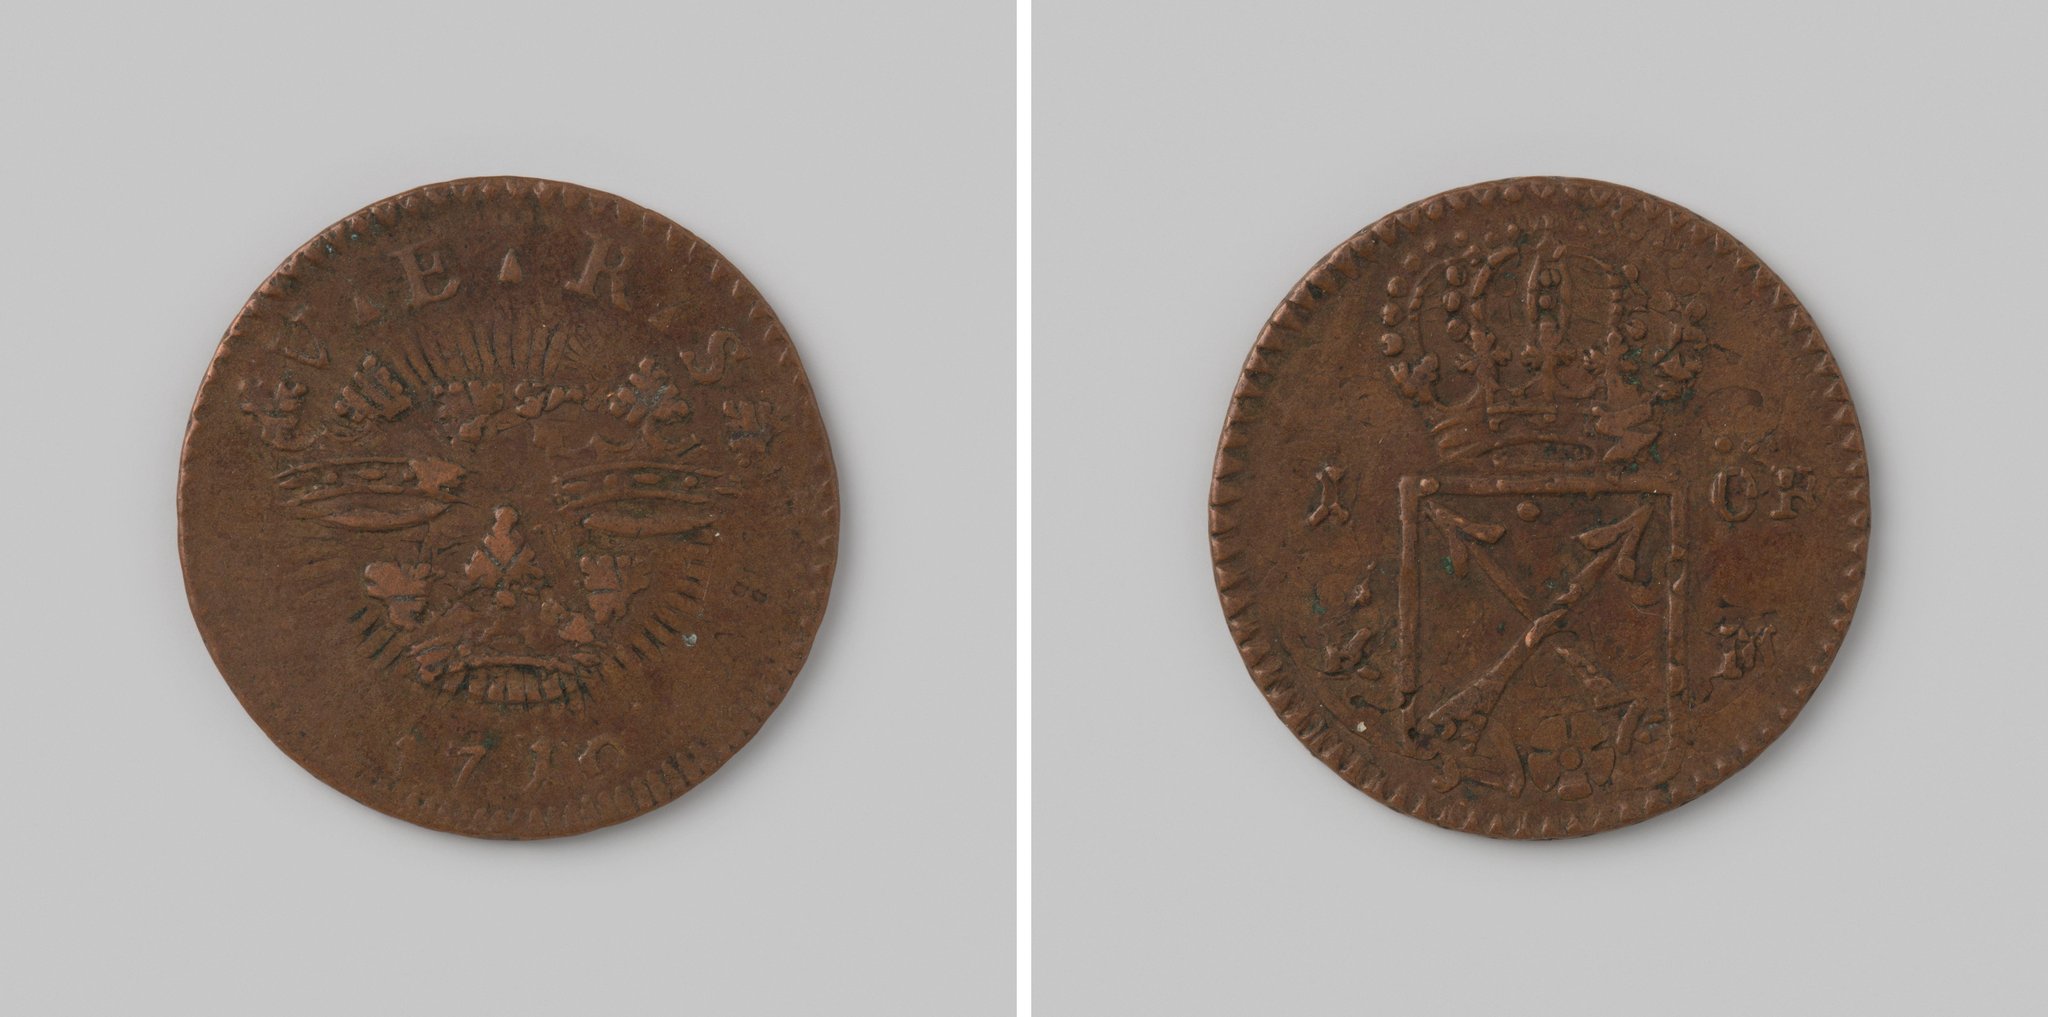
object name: coin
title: öre Koppar Mynt uit Zweden van Ulrika Eleonora,1719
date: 1719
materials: copper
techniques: striking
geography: slot rörstrand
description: Koperen munt. Voorzijde: tussen drie kronen letters V,,E,R en S. Daaronder jaartal. Keerzijde: tussen waarde-aanduiding gekroond wapenschild. Kabelrand. Op muntplaatje van nooddaler 1715-1718 geslagen.